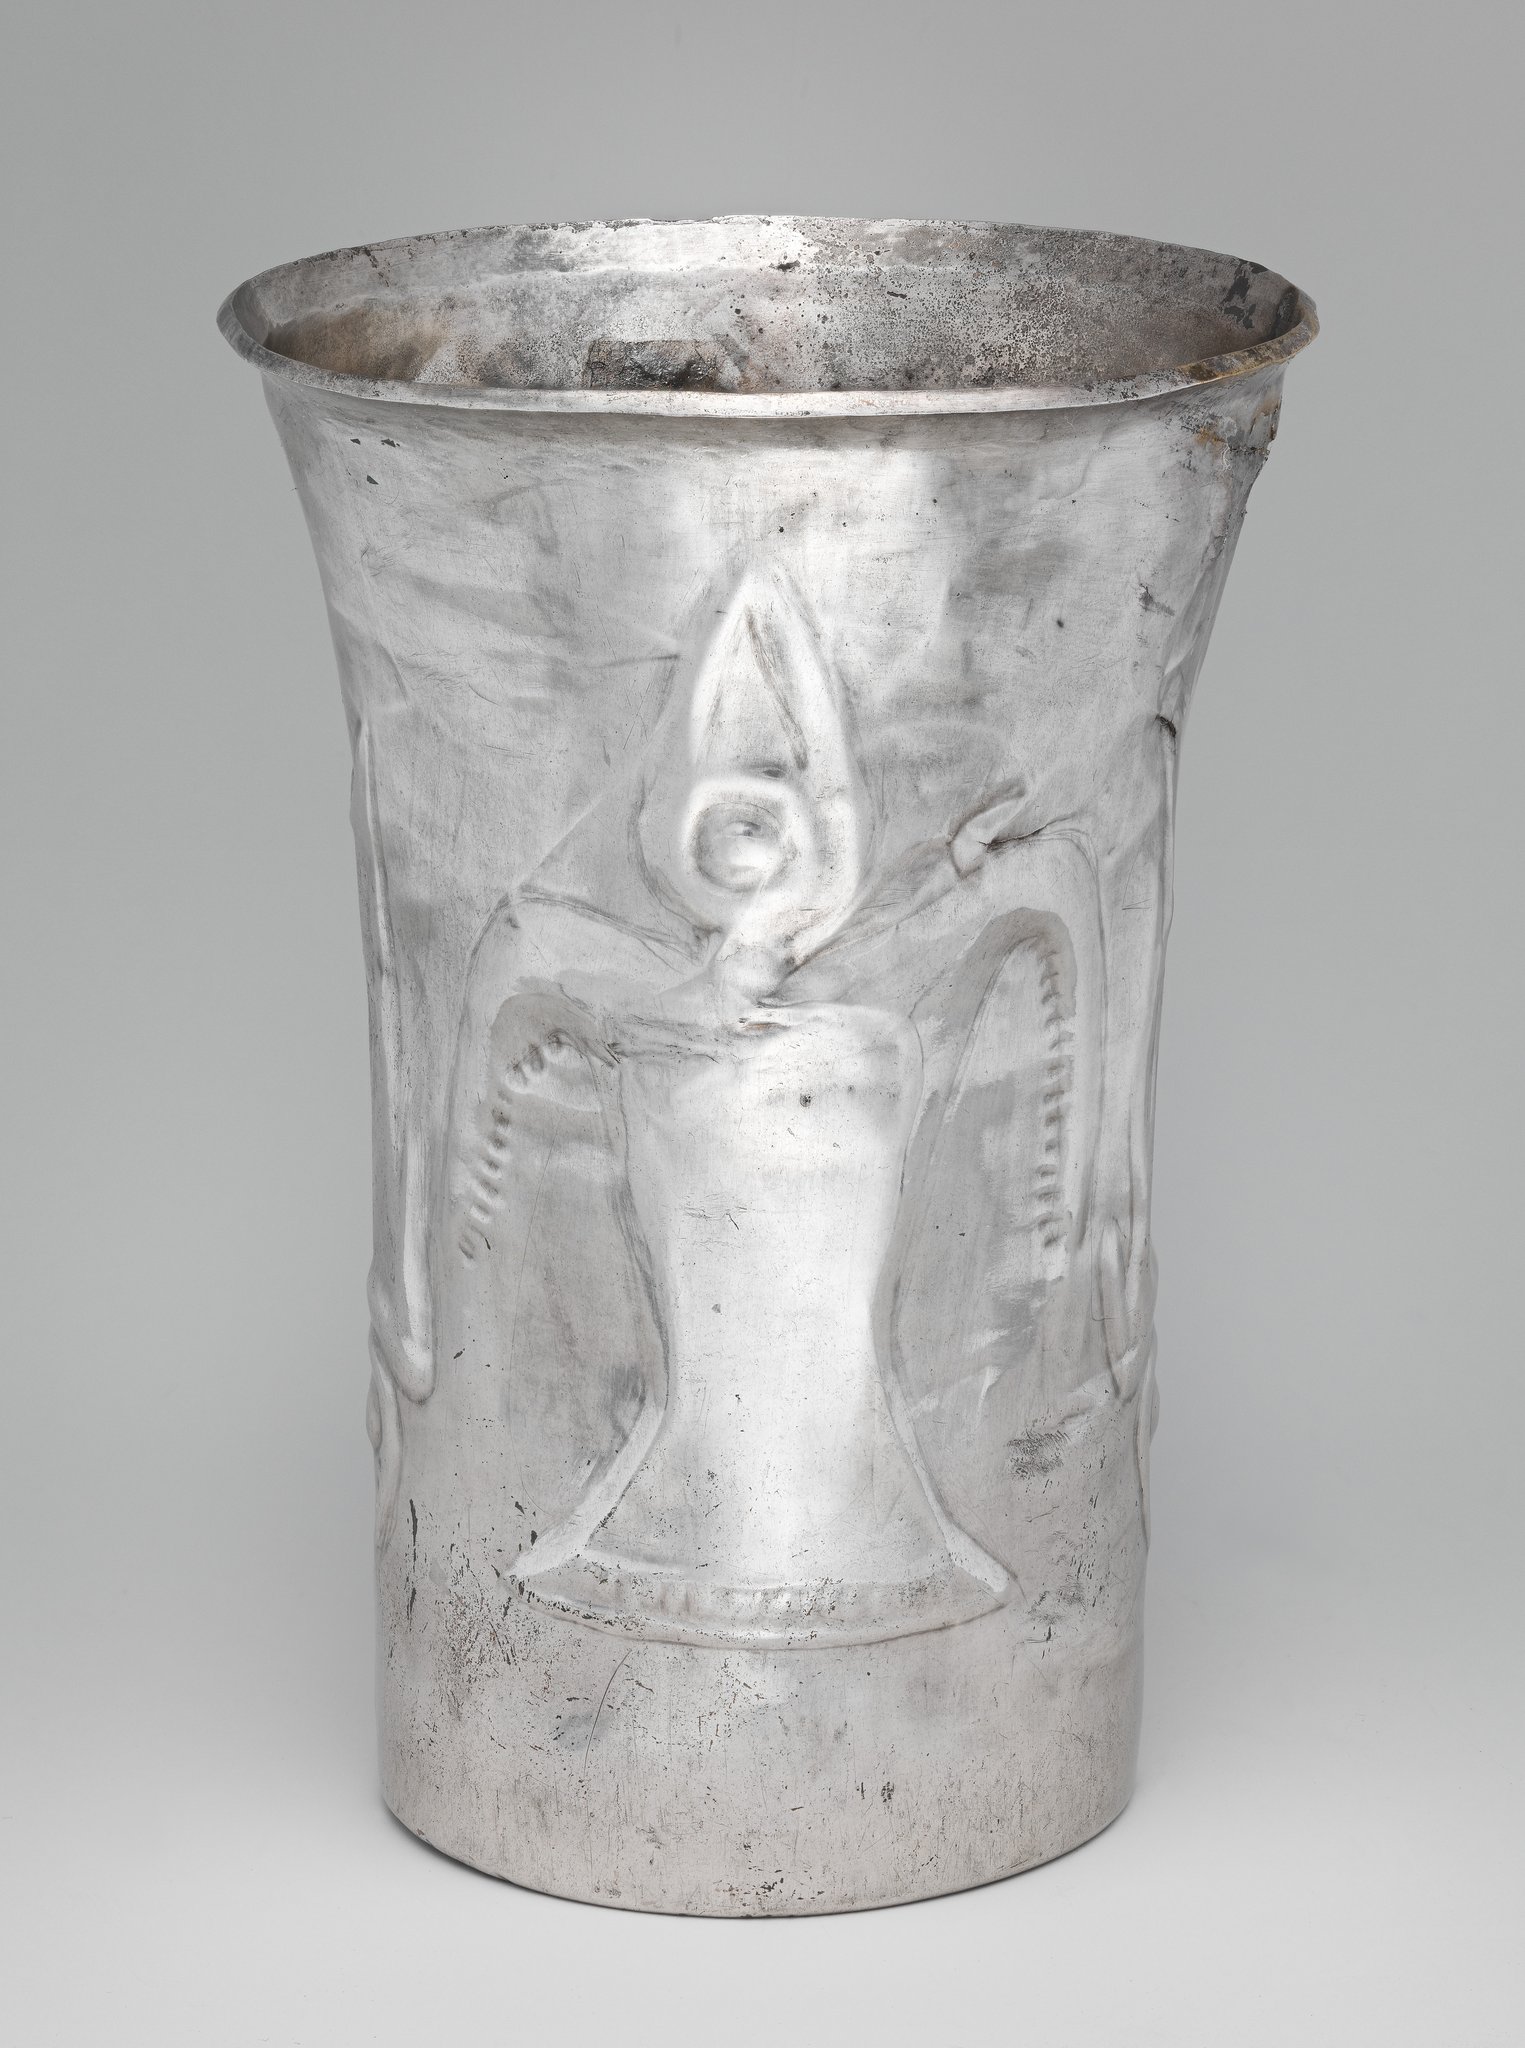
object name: beaker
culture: chimú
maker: chimú artist(s)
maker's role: artist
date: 1100-1470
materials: silver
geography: peru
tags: birds